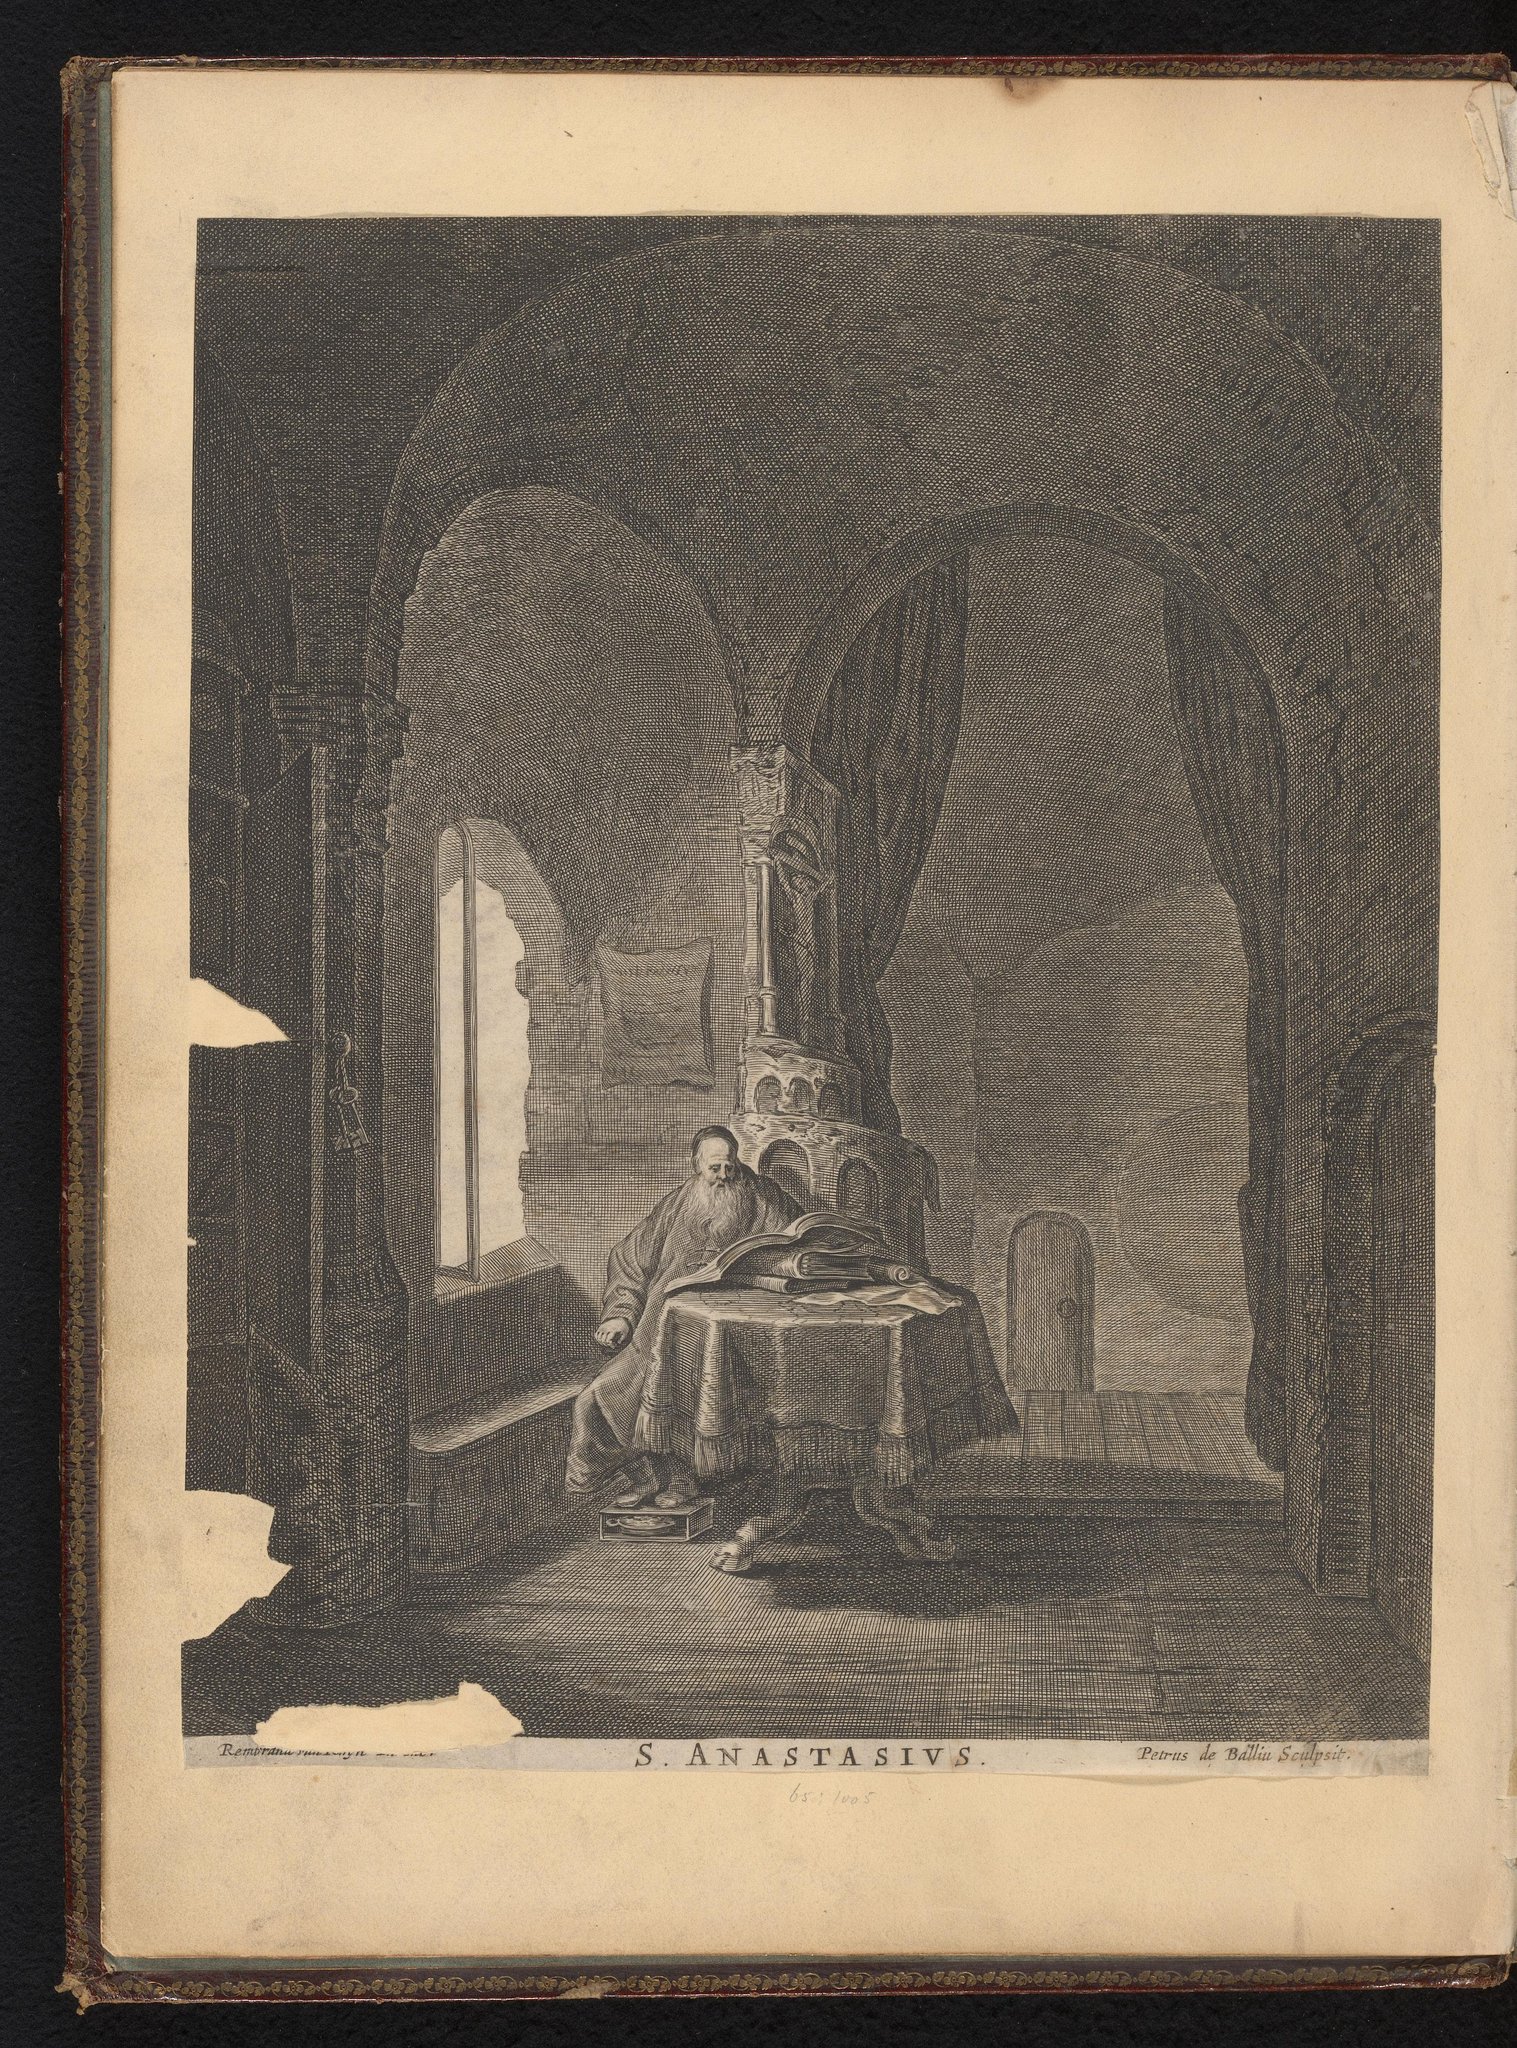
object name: print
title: H. Athanasius van Alexandrië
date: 1628-1660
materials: paper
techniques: engraving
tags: specific aspects ~ st. athanasius, saints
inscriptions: signature: ‘Rembrand van Rhyn [...]’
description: Prent maakt mogelijk deel uit van een serie van 200 prenten. Deze serie is onder de titel 'A Collection of two hundred original etchings' voor het eerst uitgegeven door J.M. Greery in 1816.